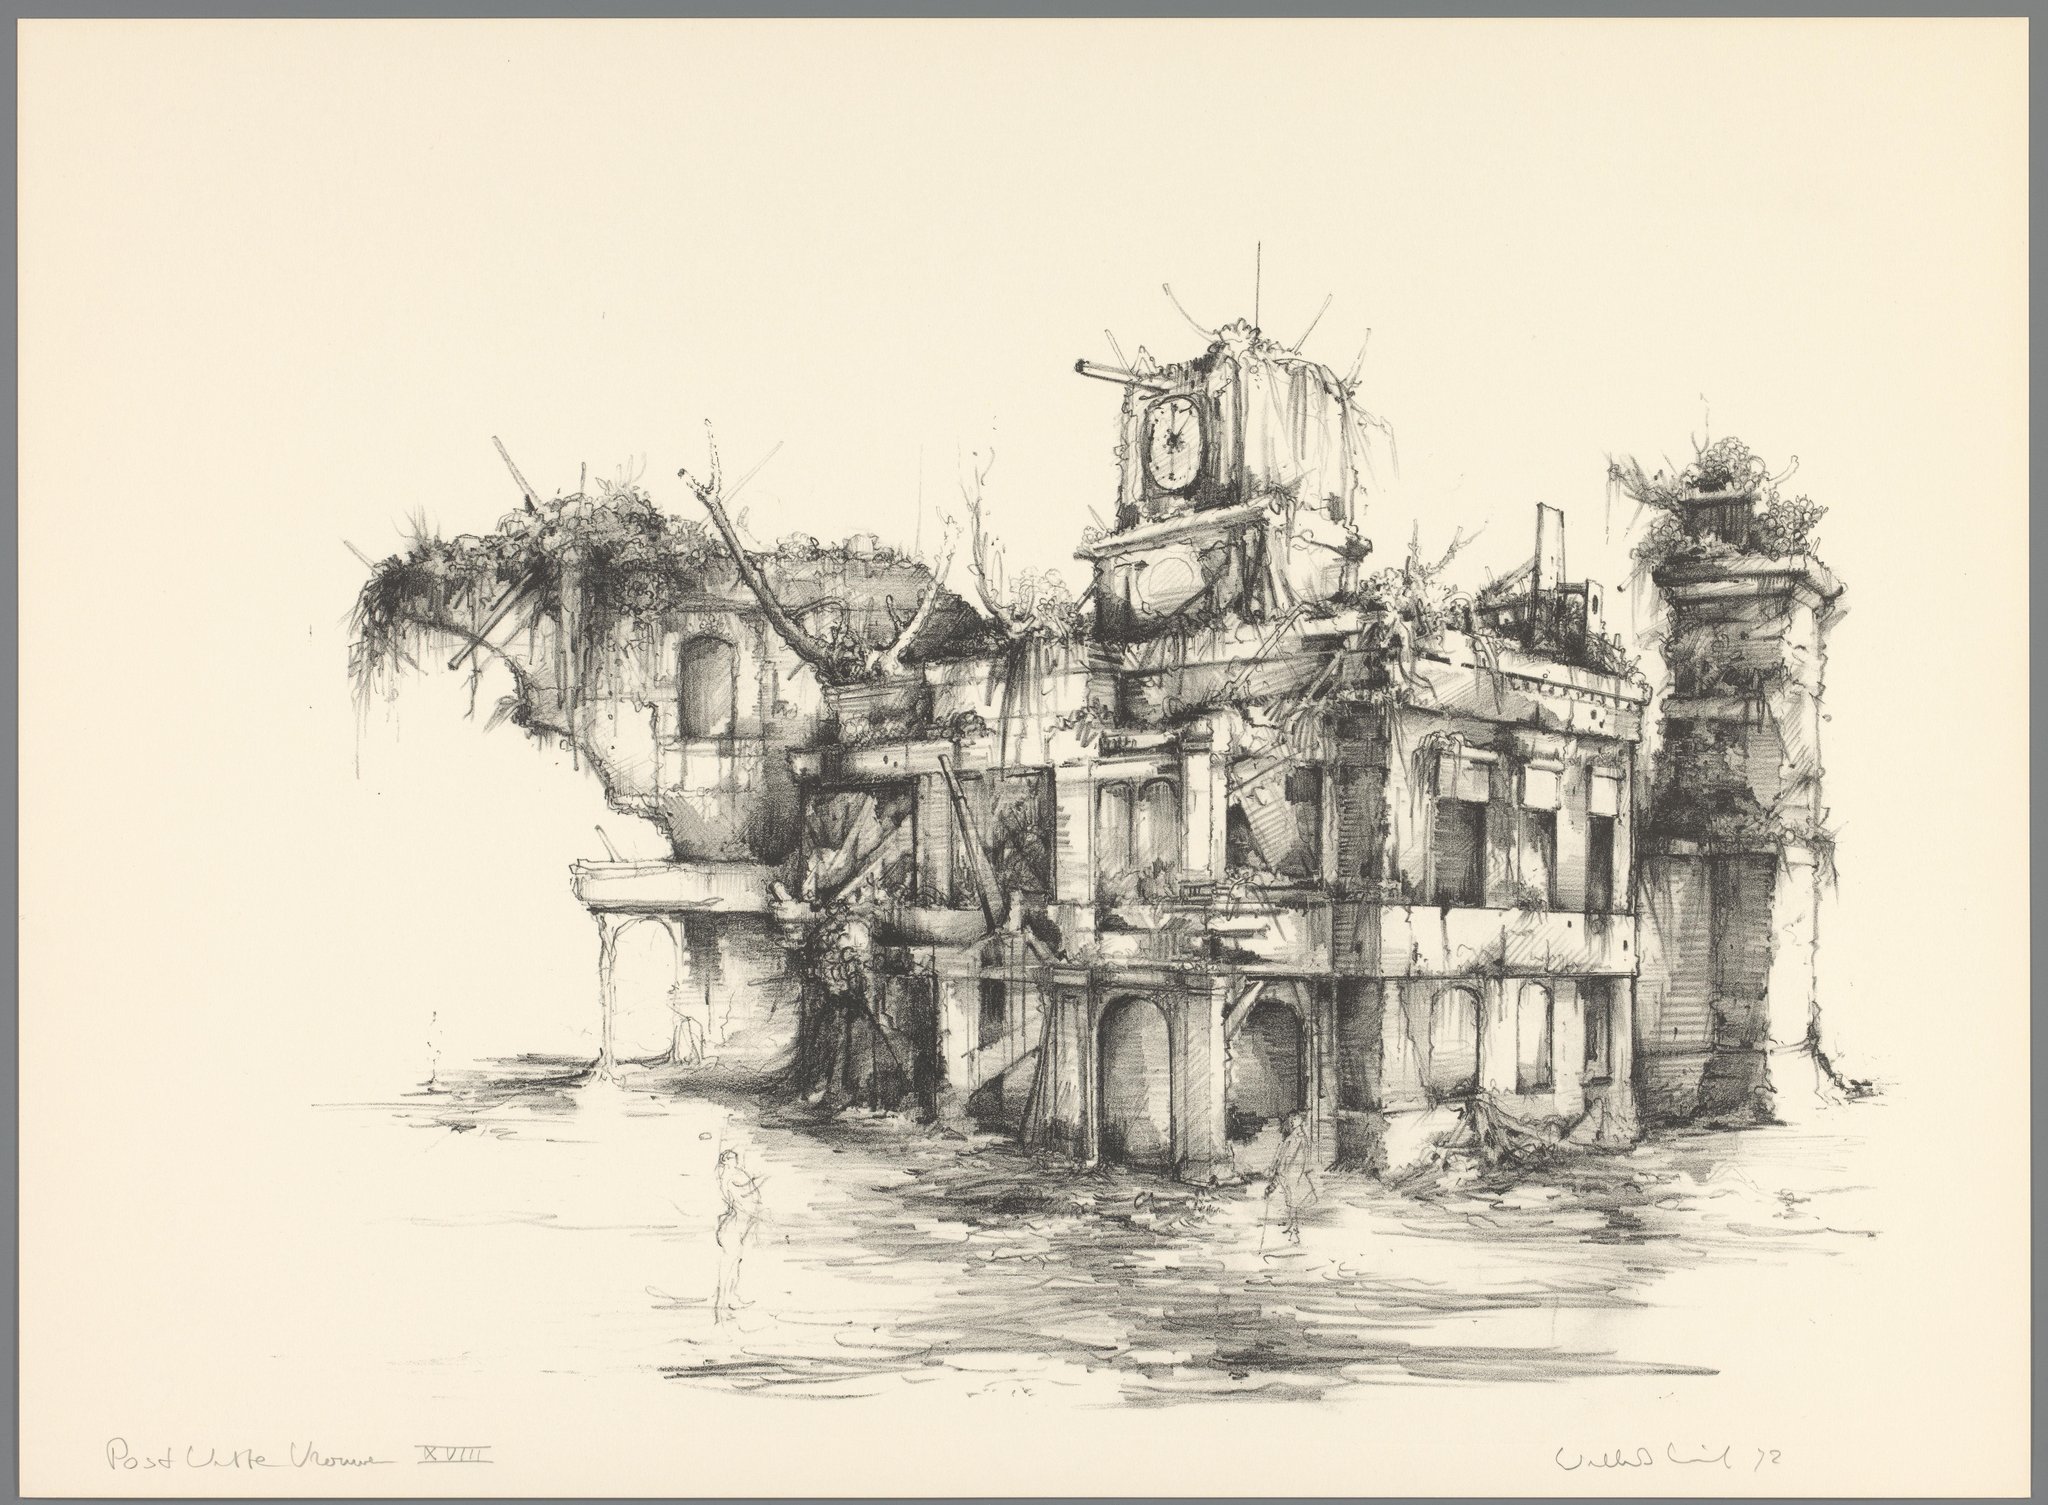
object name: print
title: Tien gezichten op Utrecht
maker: dirkje kuik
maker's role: print maker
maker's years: 1929-2008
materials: ink, paper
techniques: lithograph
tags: ruin of a building ~ architecture, city-view in general; 'veduta' - ii - ideal city, utrecht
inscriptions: signature and date: ‘WillD Kuik 72’, title: ‘Post Witte Vrouwen’, edition: ‘XVIII’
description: Gezicht op een ruïne, met rechts van het midden een soort toren met een klok, voor de ruïne twee geabstraheerde figuren.